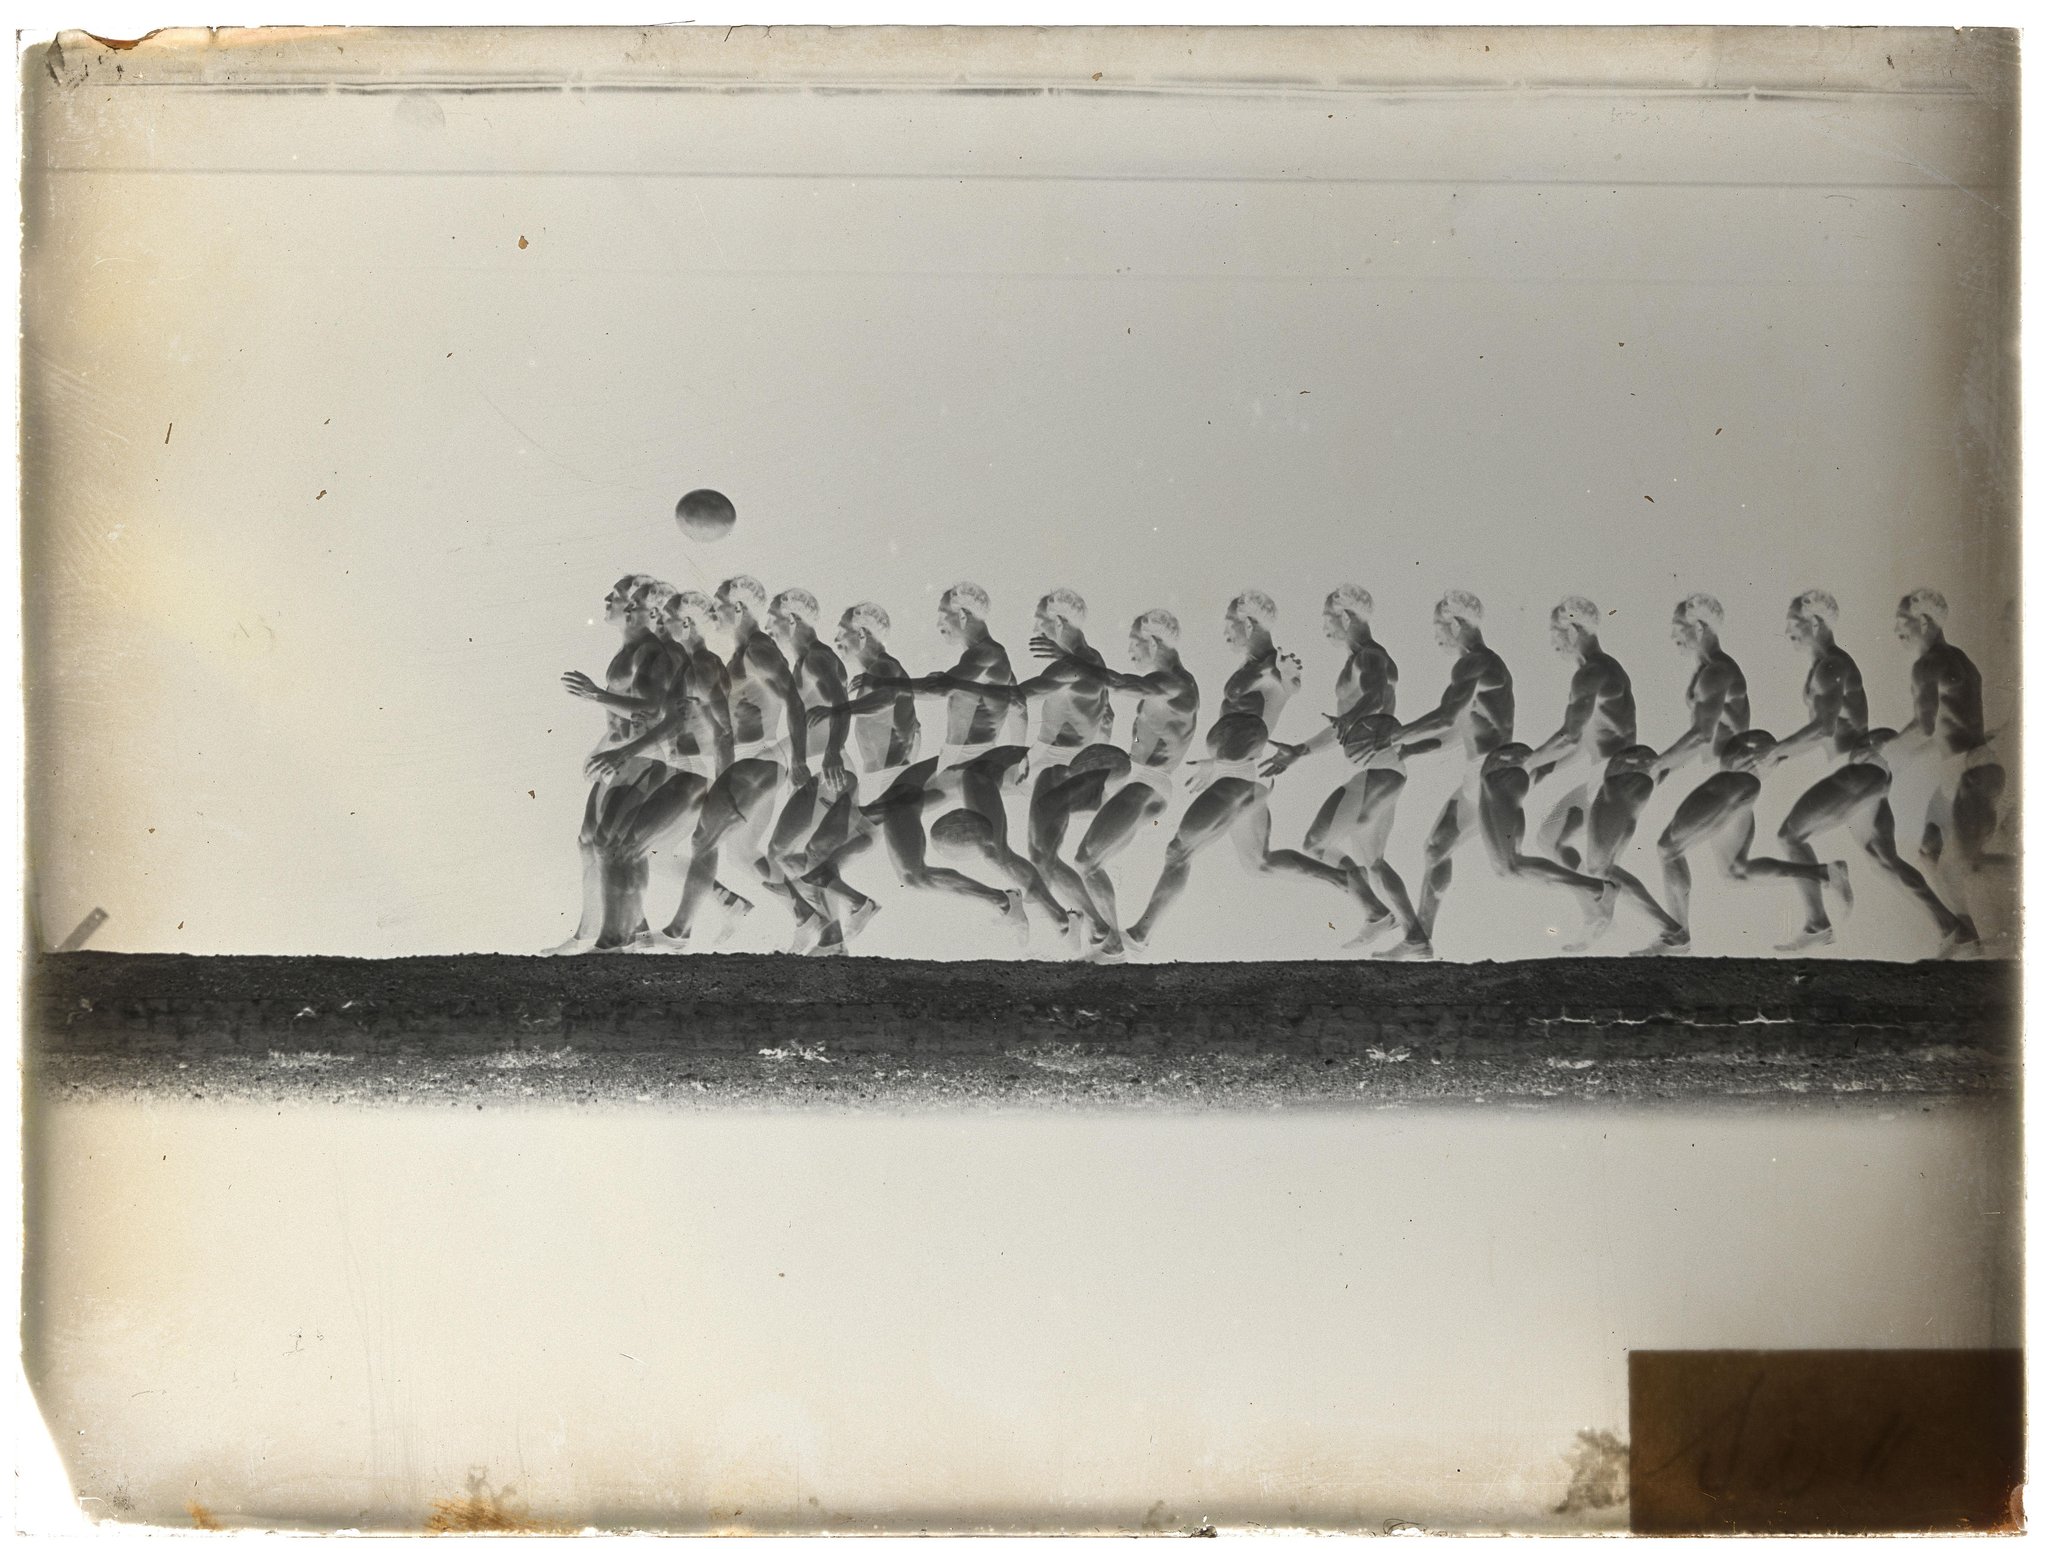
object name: glasnegatief, glasplaatnegatief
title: Man houdt bal in de hand en kopt hem weg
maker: étienne-jules marey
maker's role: fotograaf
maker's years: 1830-1904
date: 1882-1890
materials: glass, paper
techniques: gelatin glass negative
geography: france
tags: movements of the human body, adult man, ball games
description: Bij de negatieven zijn ook de duplicaatnegatieven en moderne afdrukken die voor de boekpublicatie vervaardigd zijn.